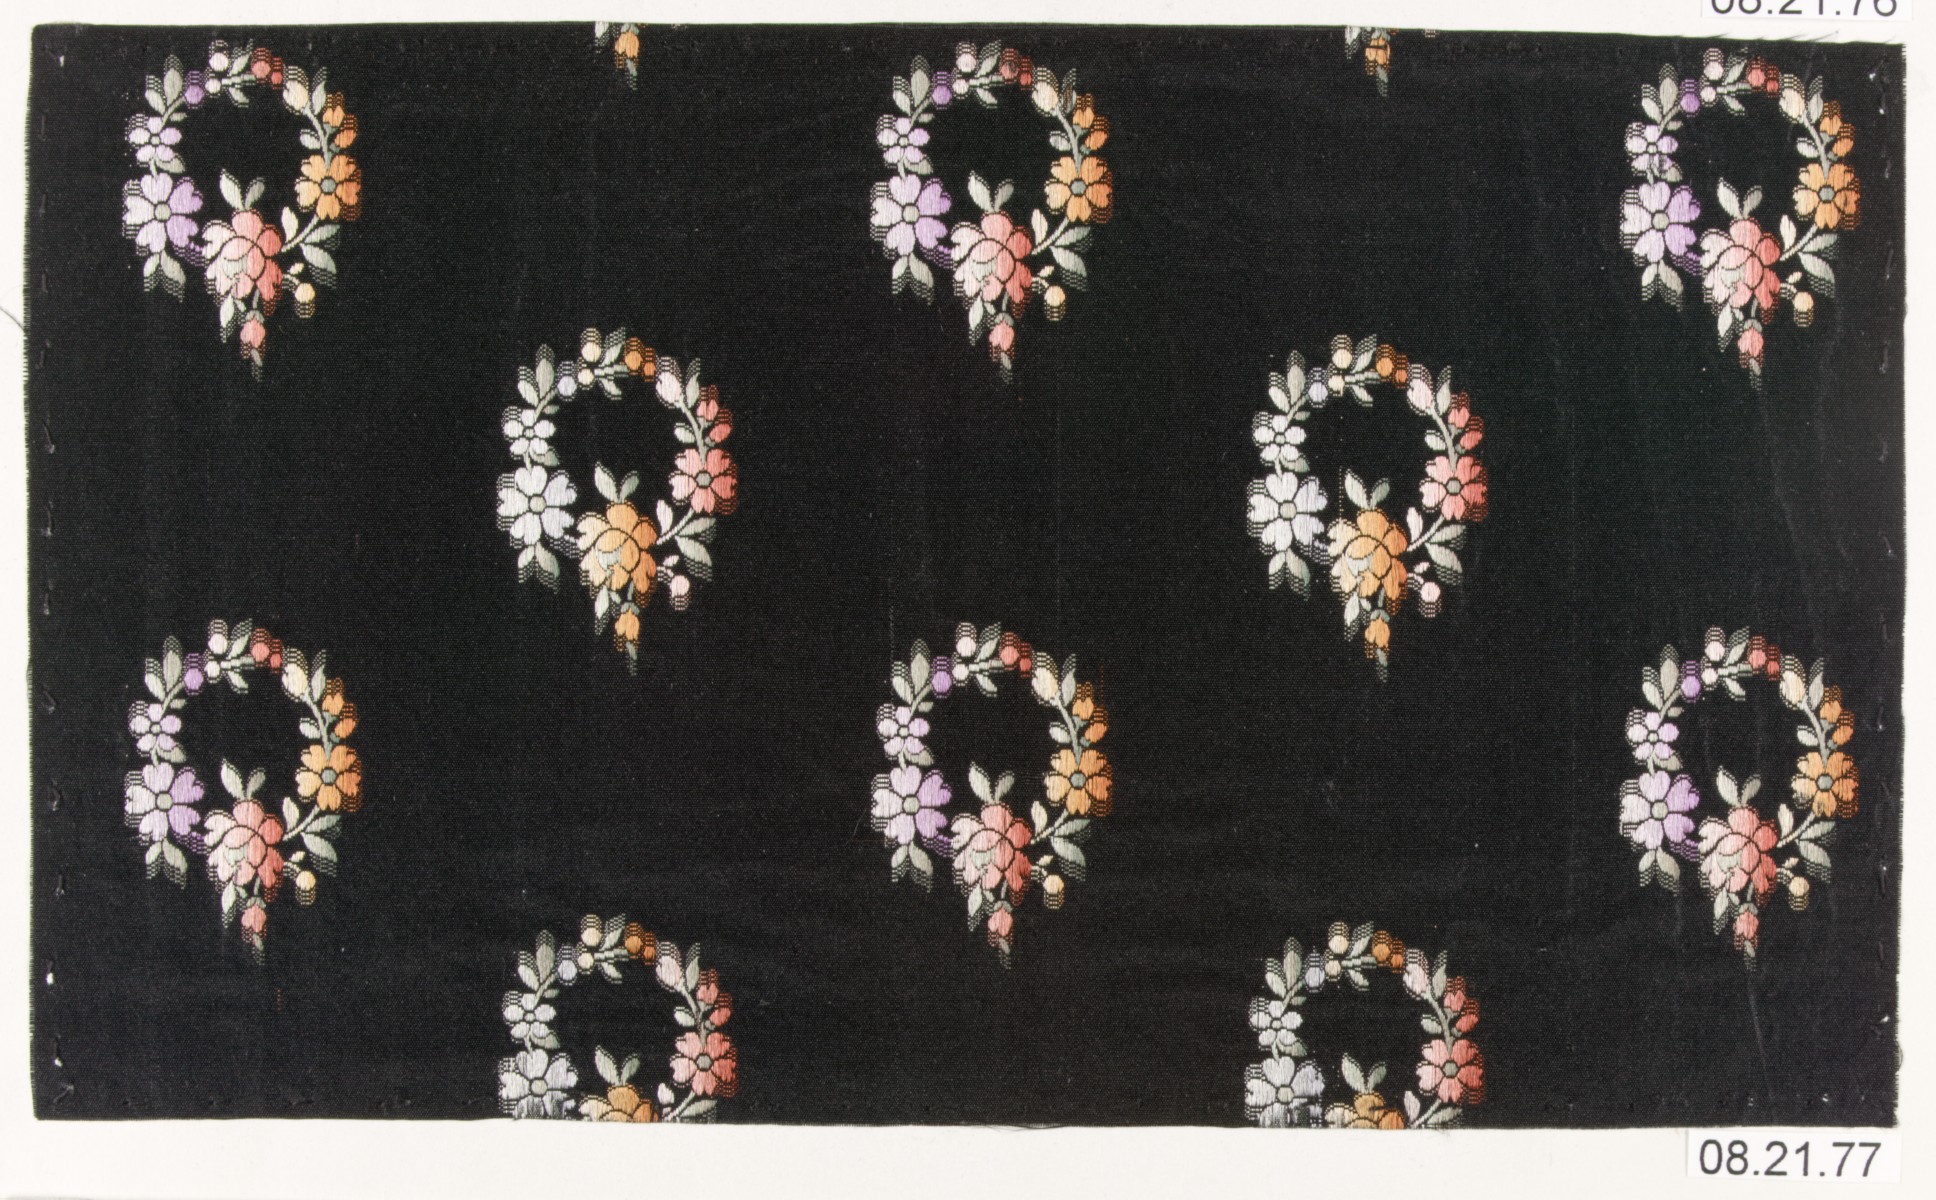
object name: textile sample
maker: Anonymous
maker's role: designer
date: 1900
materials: silk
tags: flowers